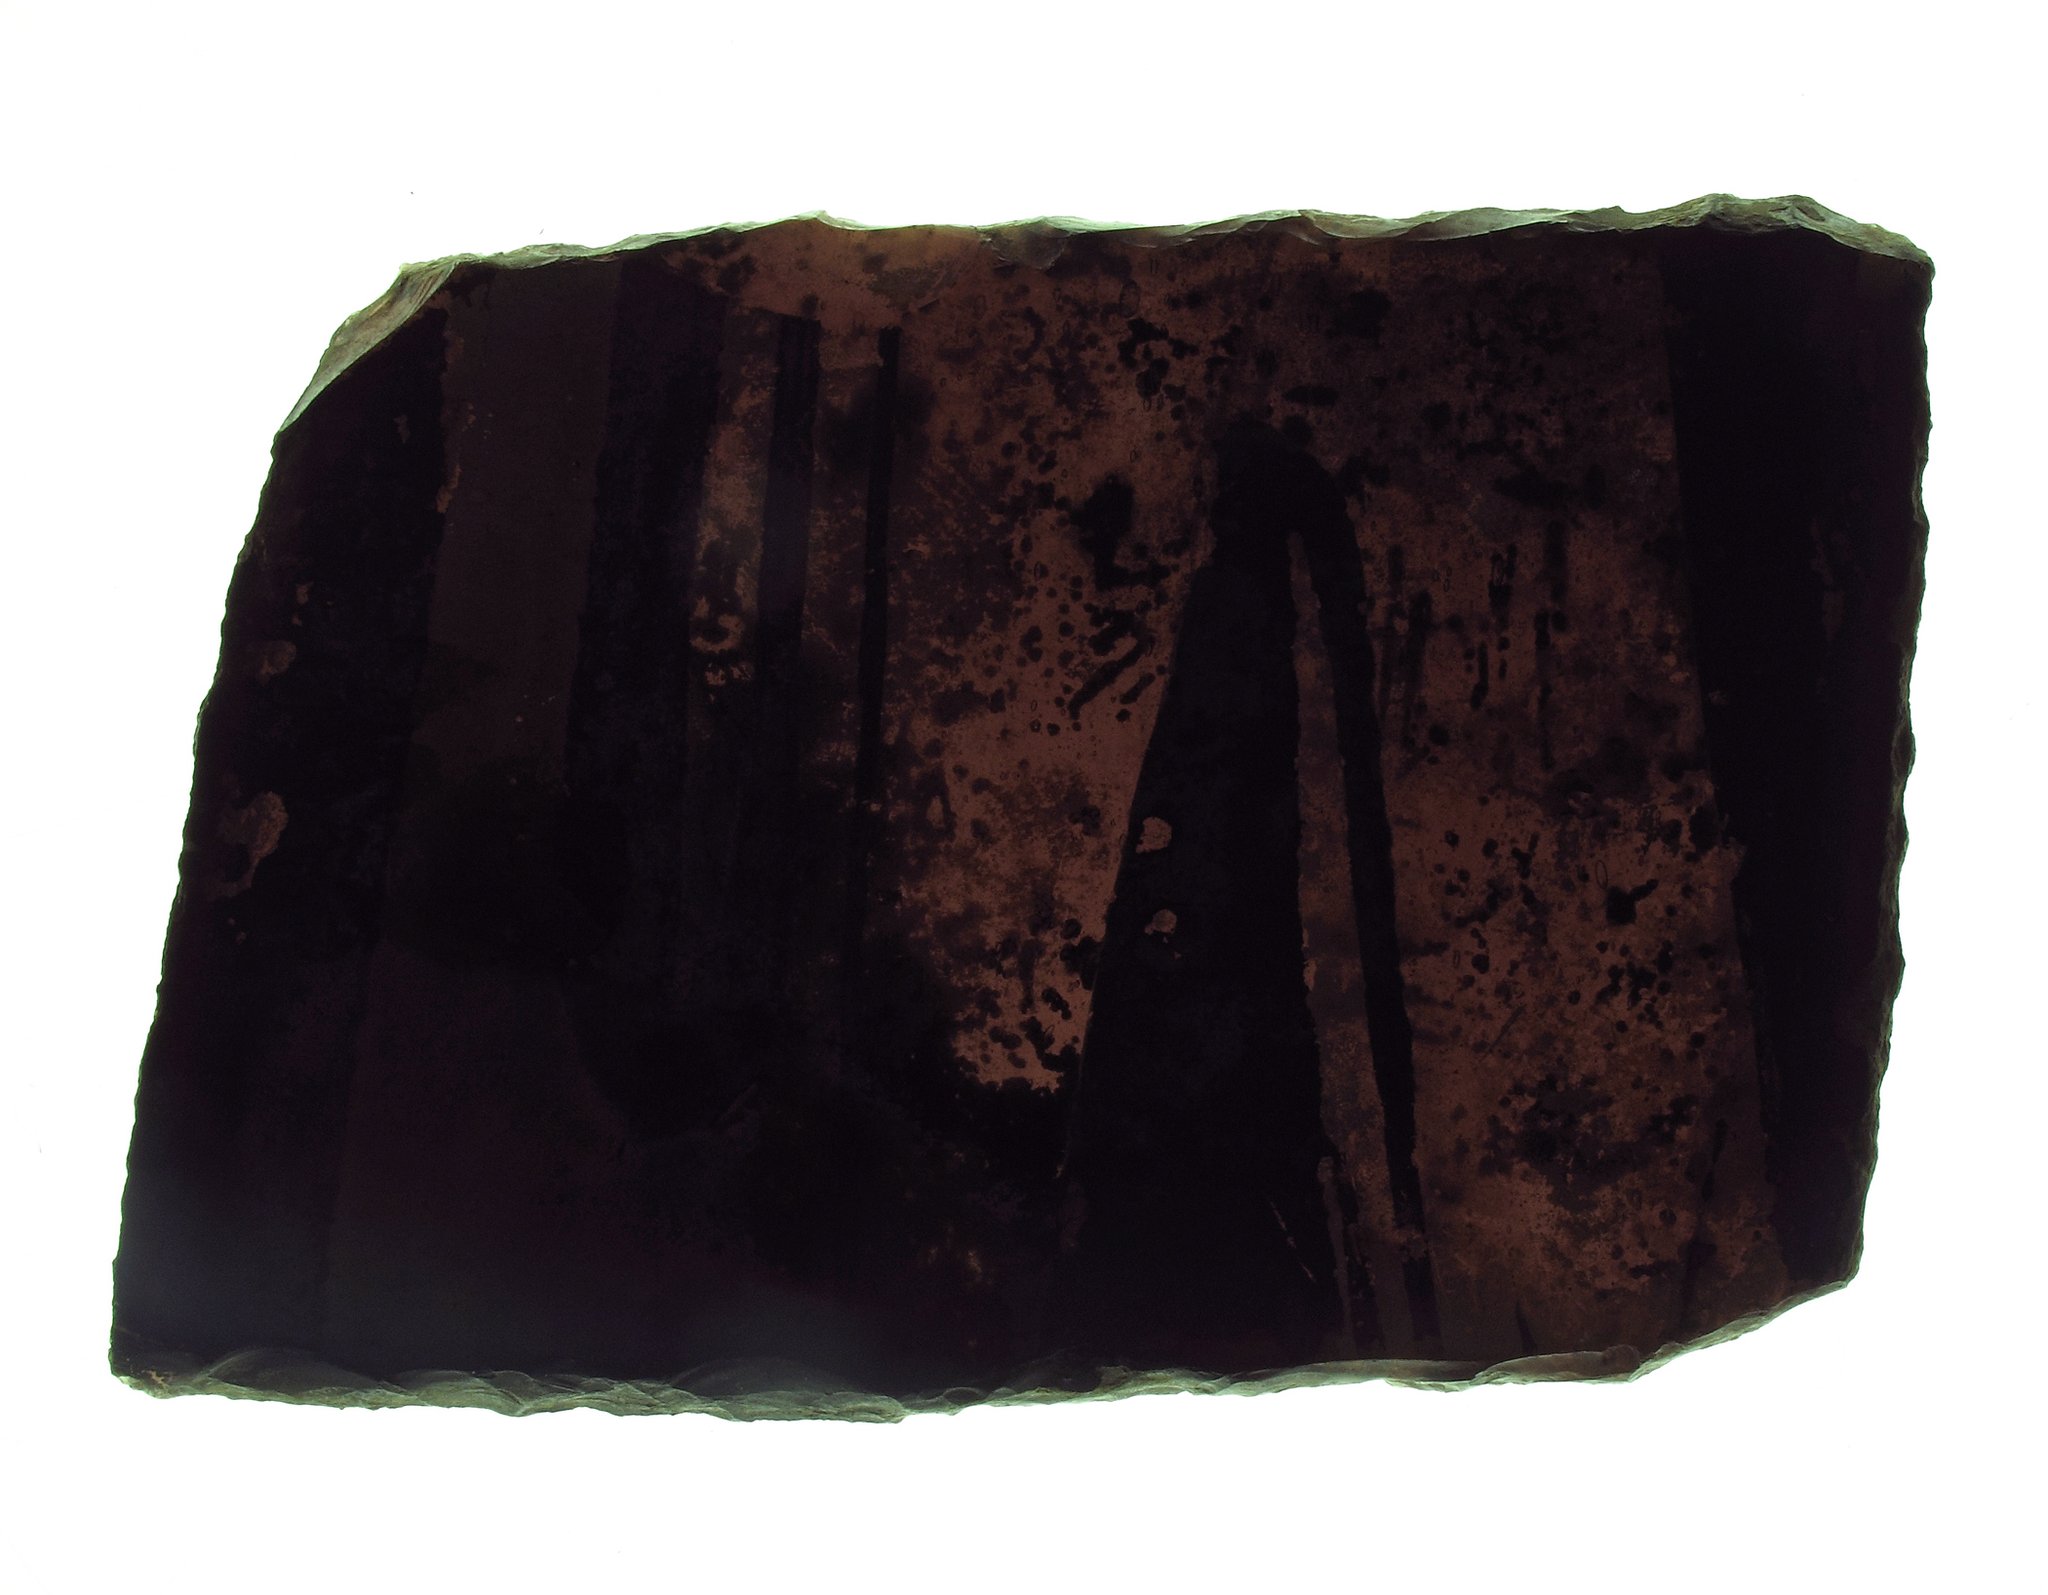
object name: fragment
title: Glass Fragment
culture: european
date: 1201-1400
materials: glass, metal